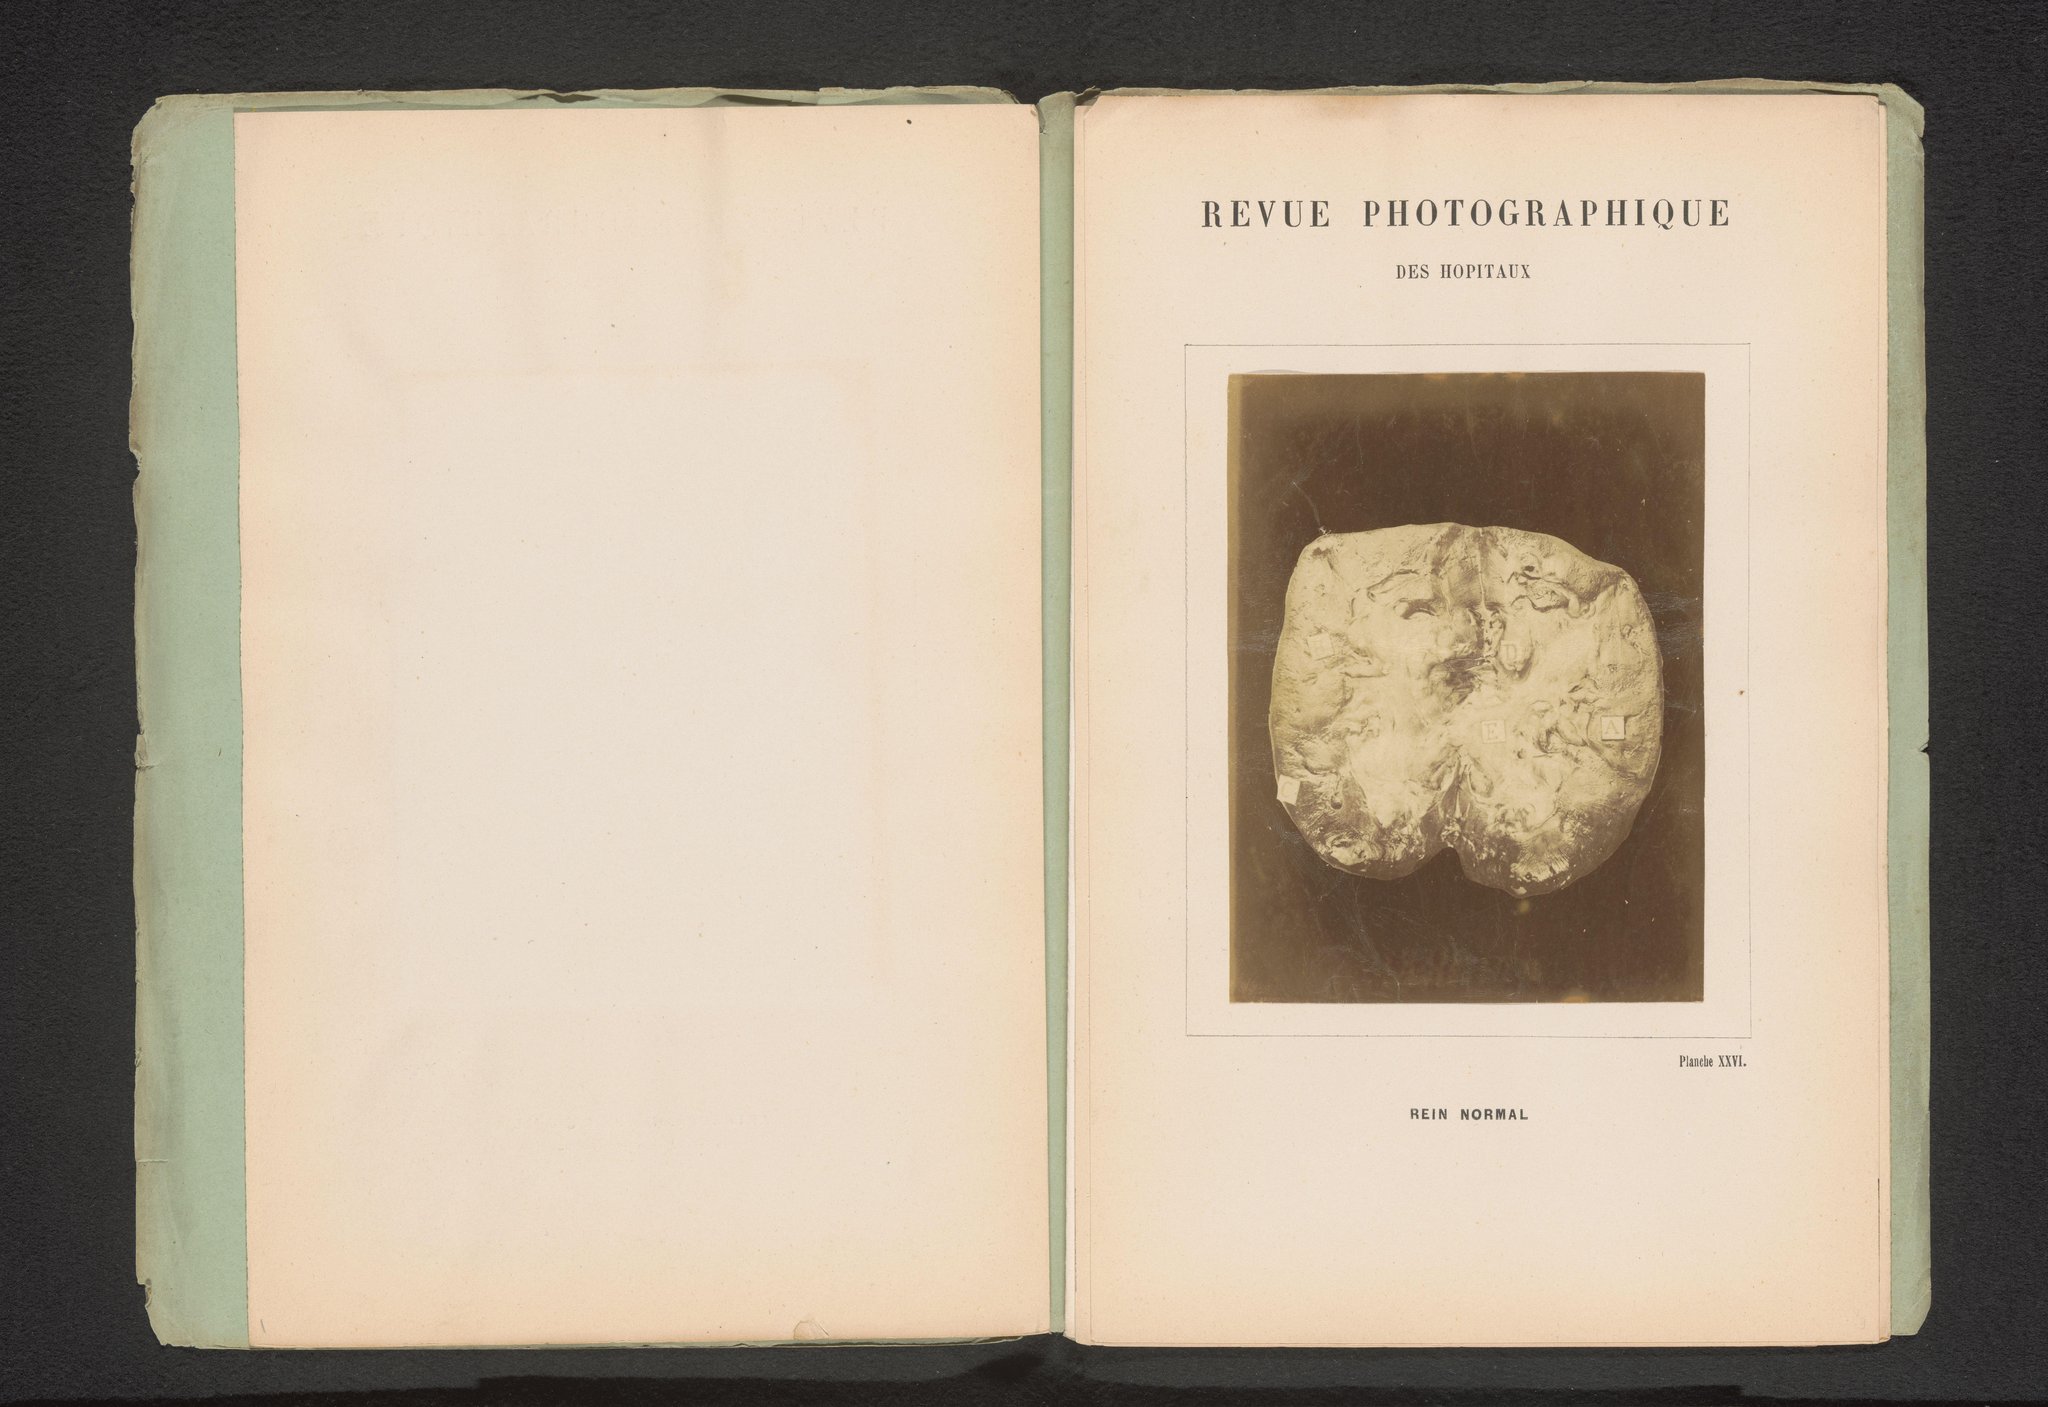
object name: page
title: rein normal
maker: Anonymous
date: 1865-1870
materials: paper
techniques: albumen print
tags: kidney, medical research, branches of medicine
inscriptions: inscription: ‘Revue photographique/ des hopitaux/ Planche XXVI.’